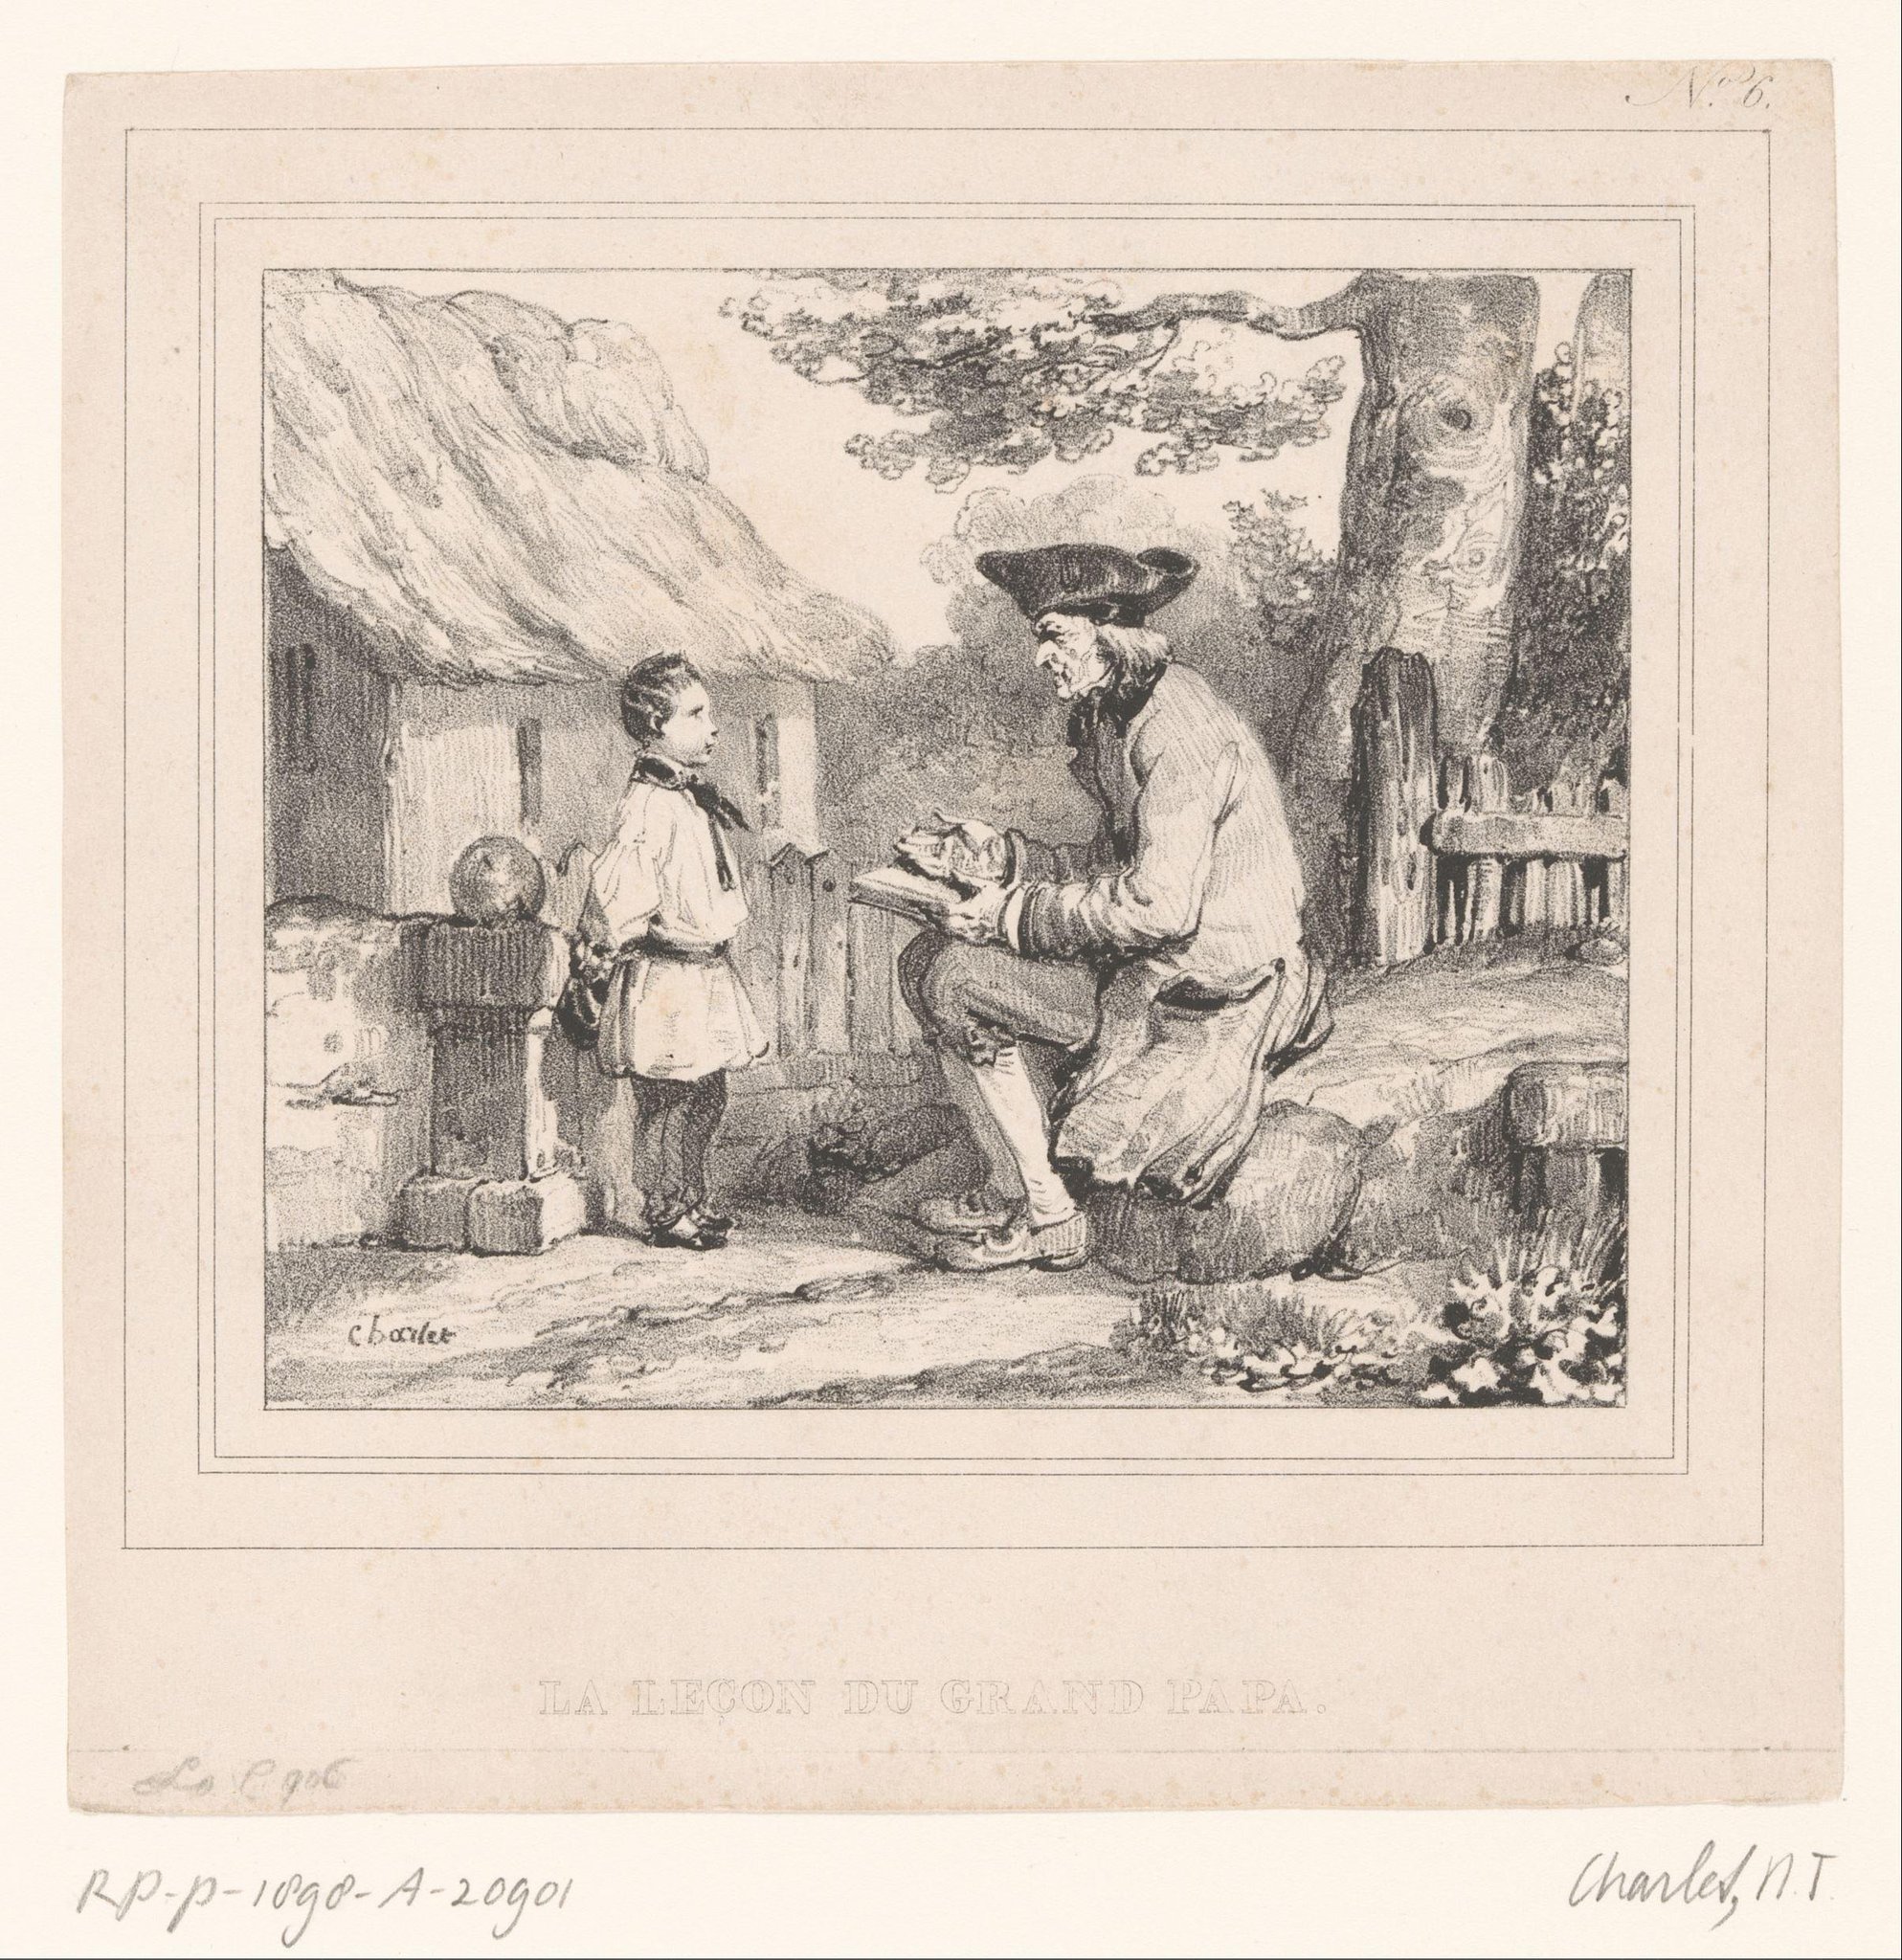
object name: print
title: La leçon du grand papa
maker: nicolas toussaint charlet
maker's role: draughtsman, painter, print maker, printer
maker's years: 1792-1845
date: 1837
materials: paper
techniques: lithograph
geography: paris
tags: grandparent(s) with grandchild(ren) (family group), education, rural life, child (at home)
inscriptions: collector's mark: Lugt 2228a